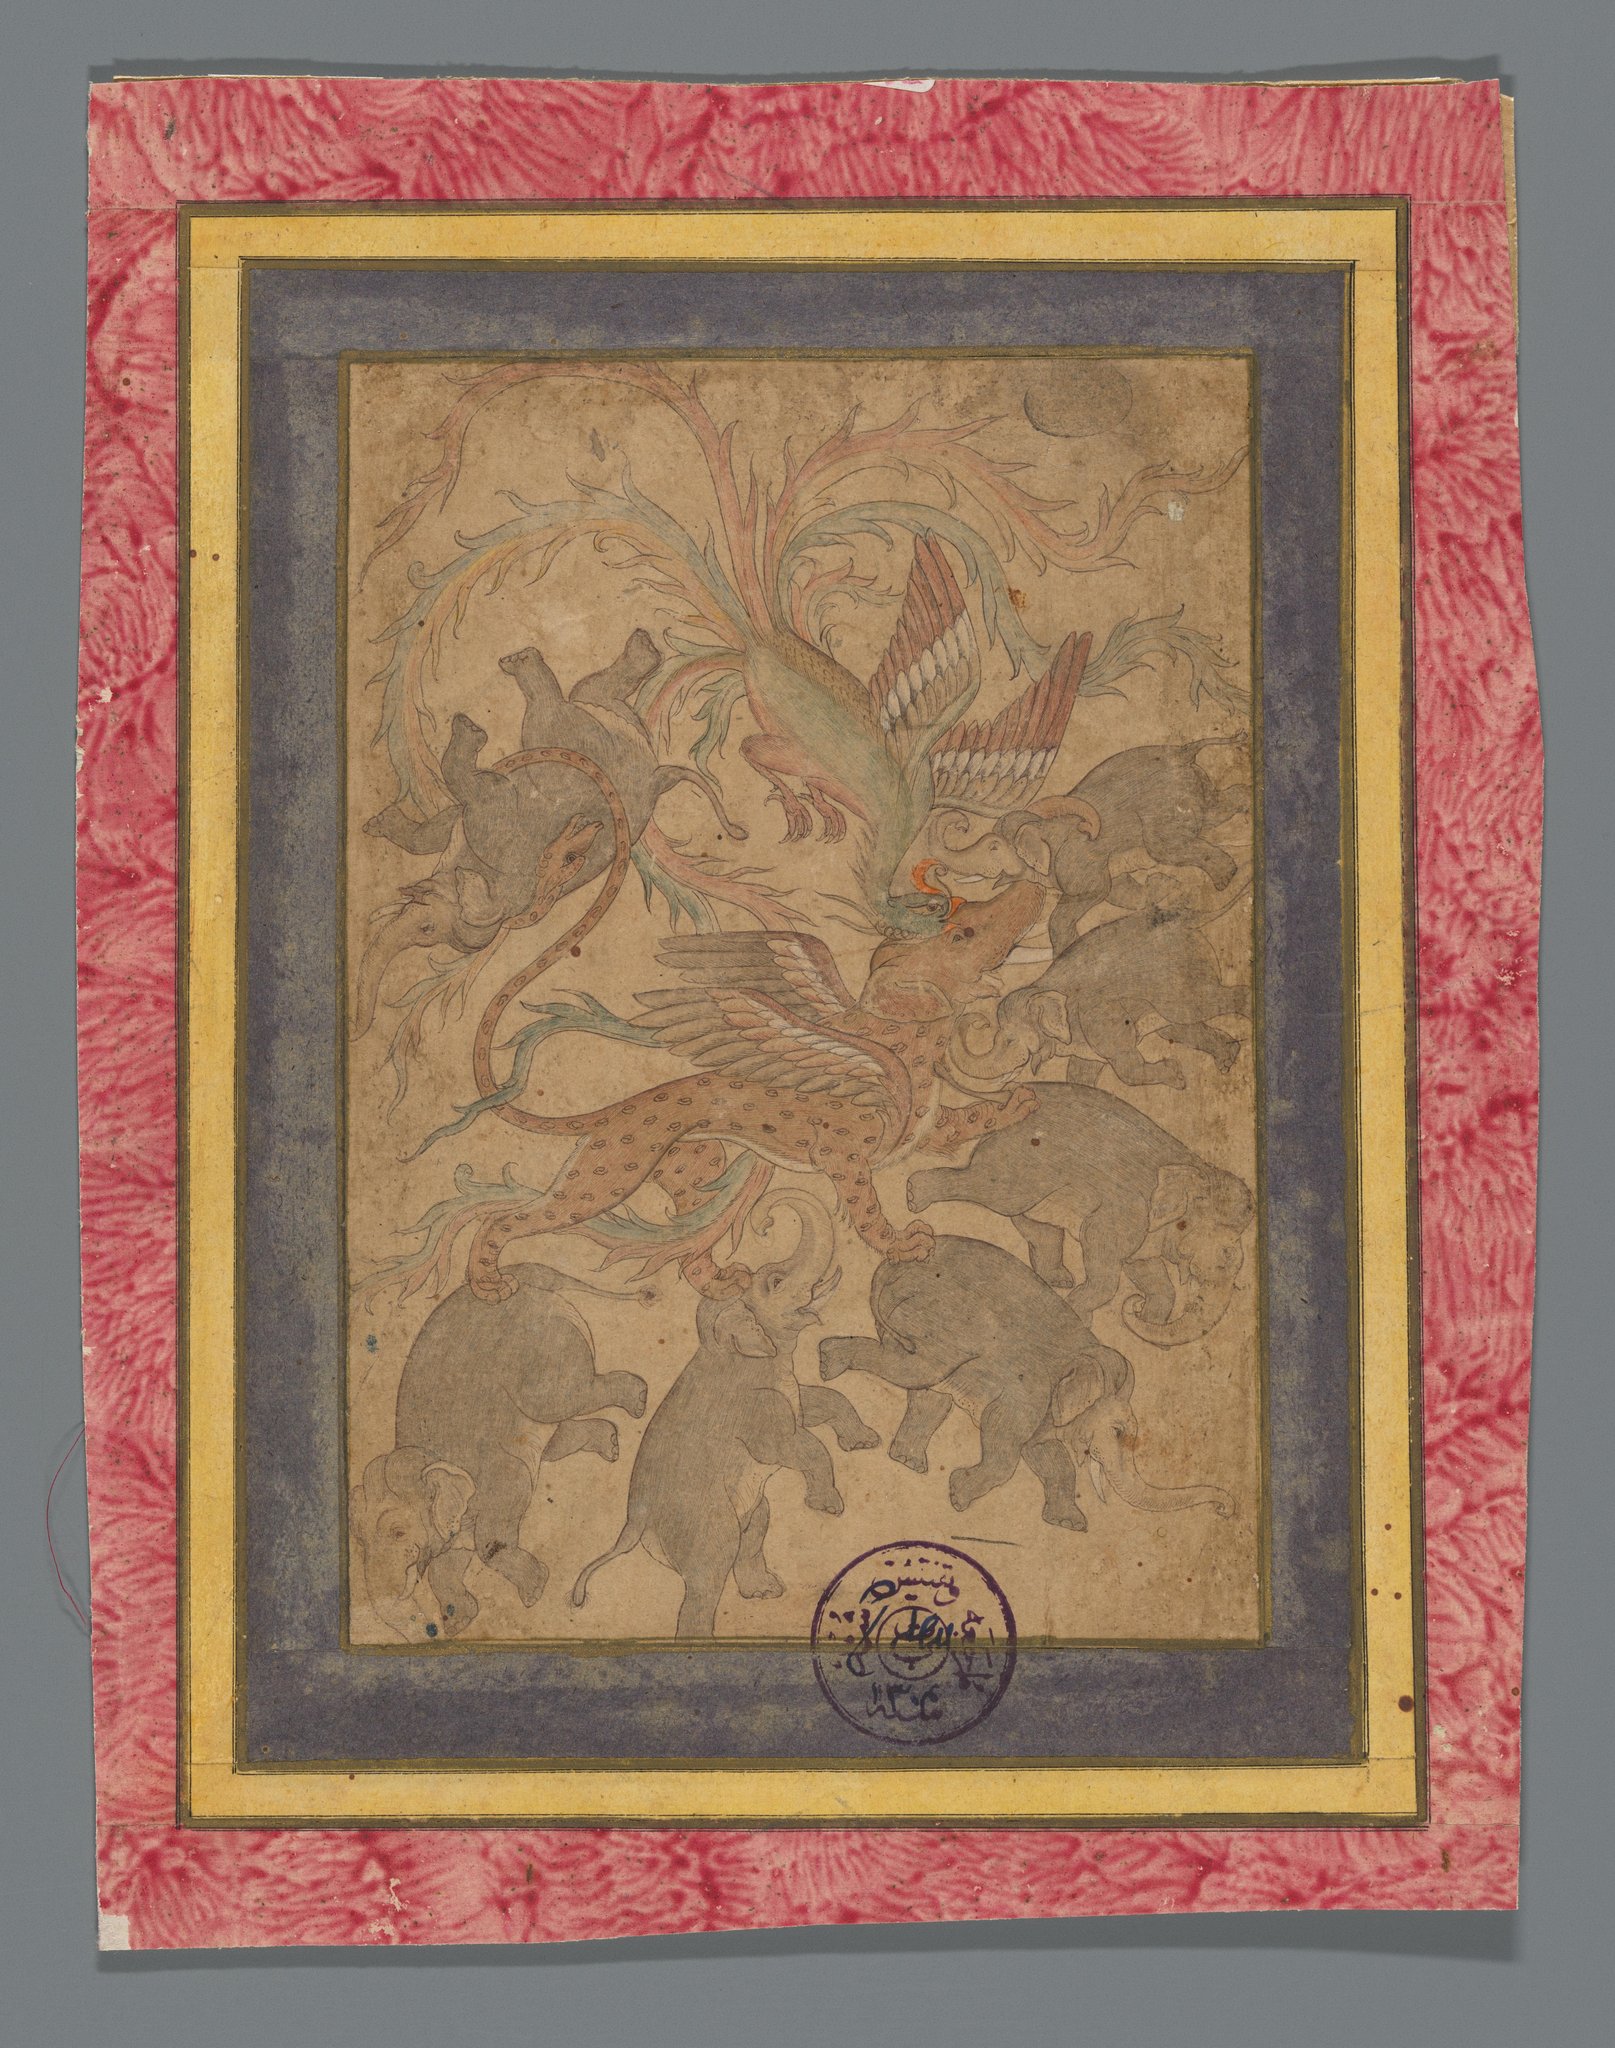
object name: indian miniature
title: Simurgh attacking a gaja-simha (elephantlion)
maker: Anonymous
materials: paper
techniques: brush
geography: india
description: Persia or Mughal India. Purchased from Mr E. Isacco, Galerie Marco Polo, Paris